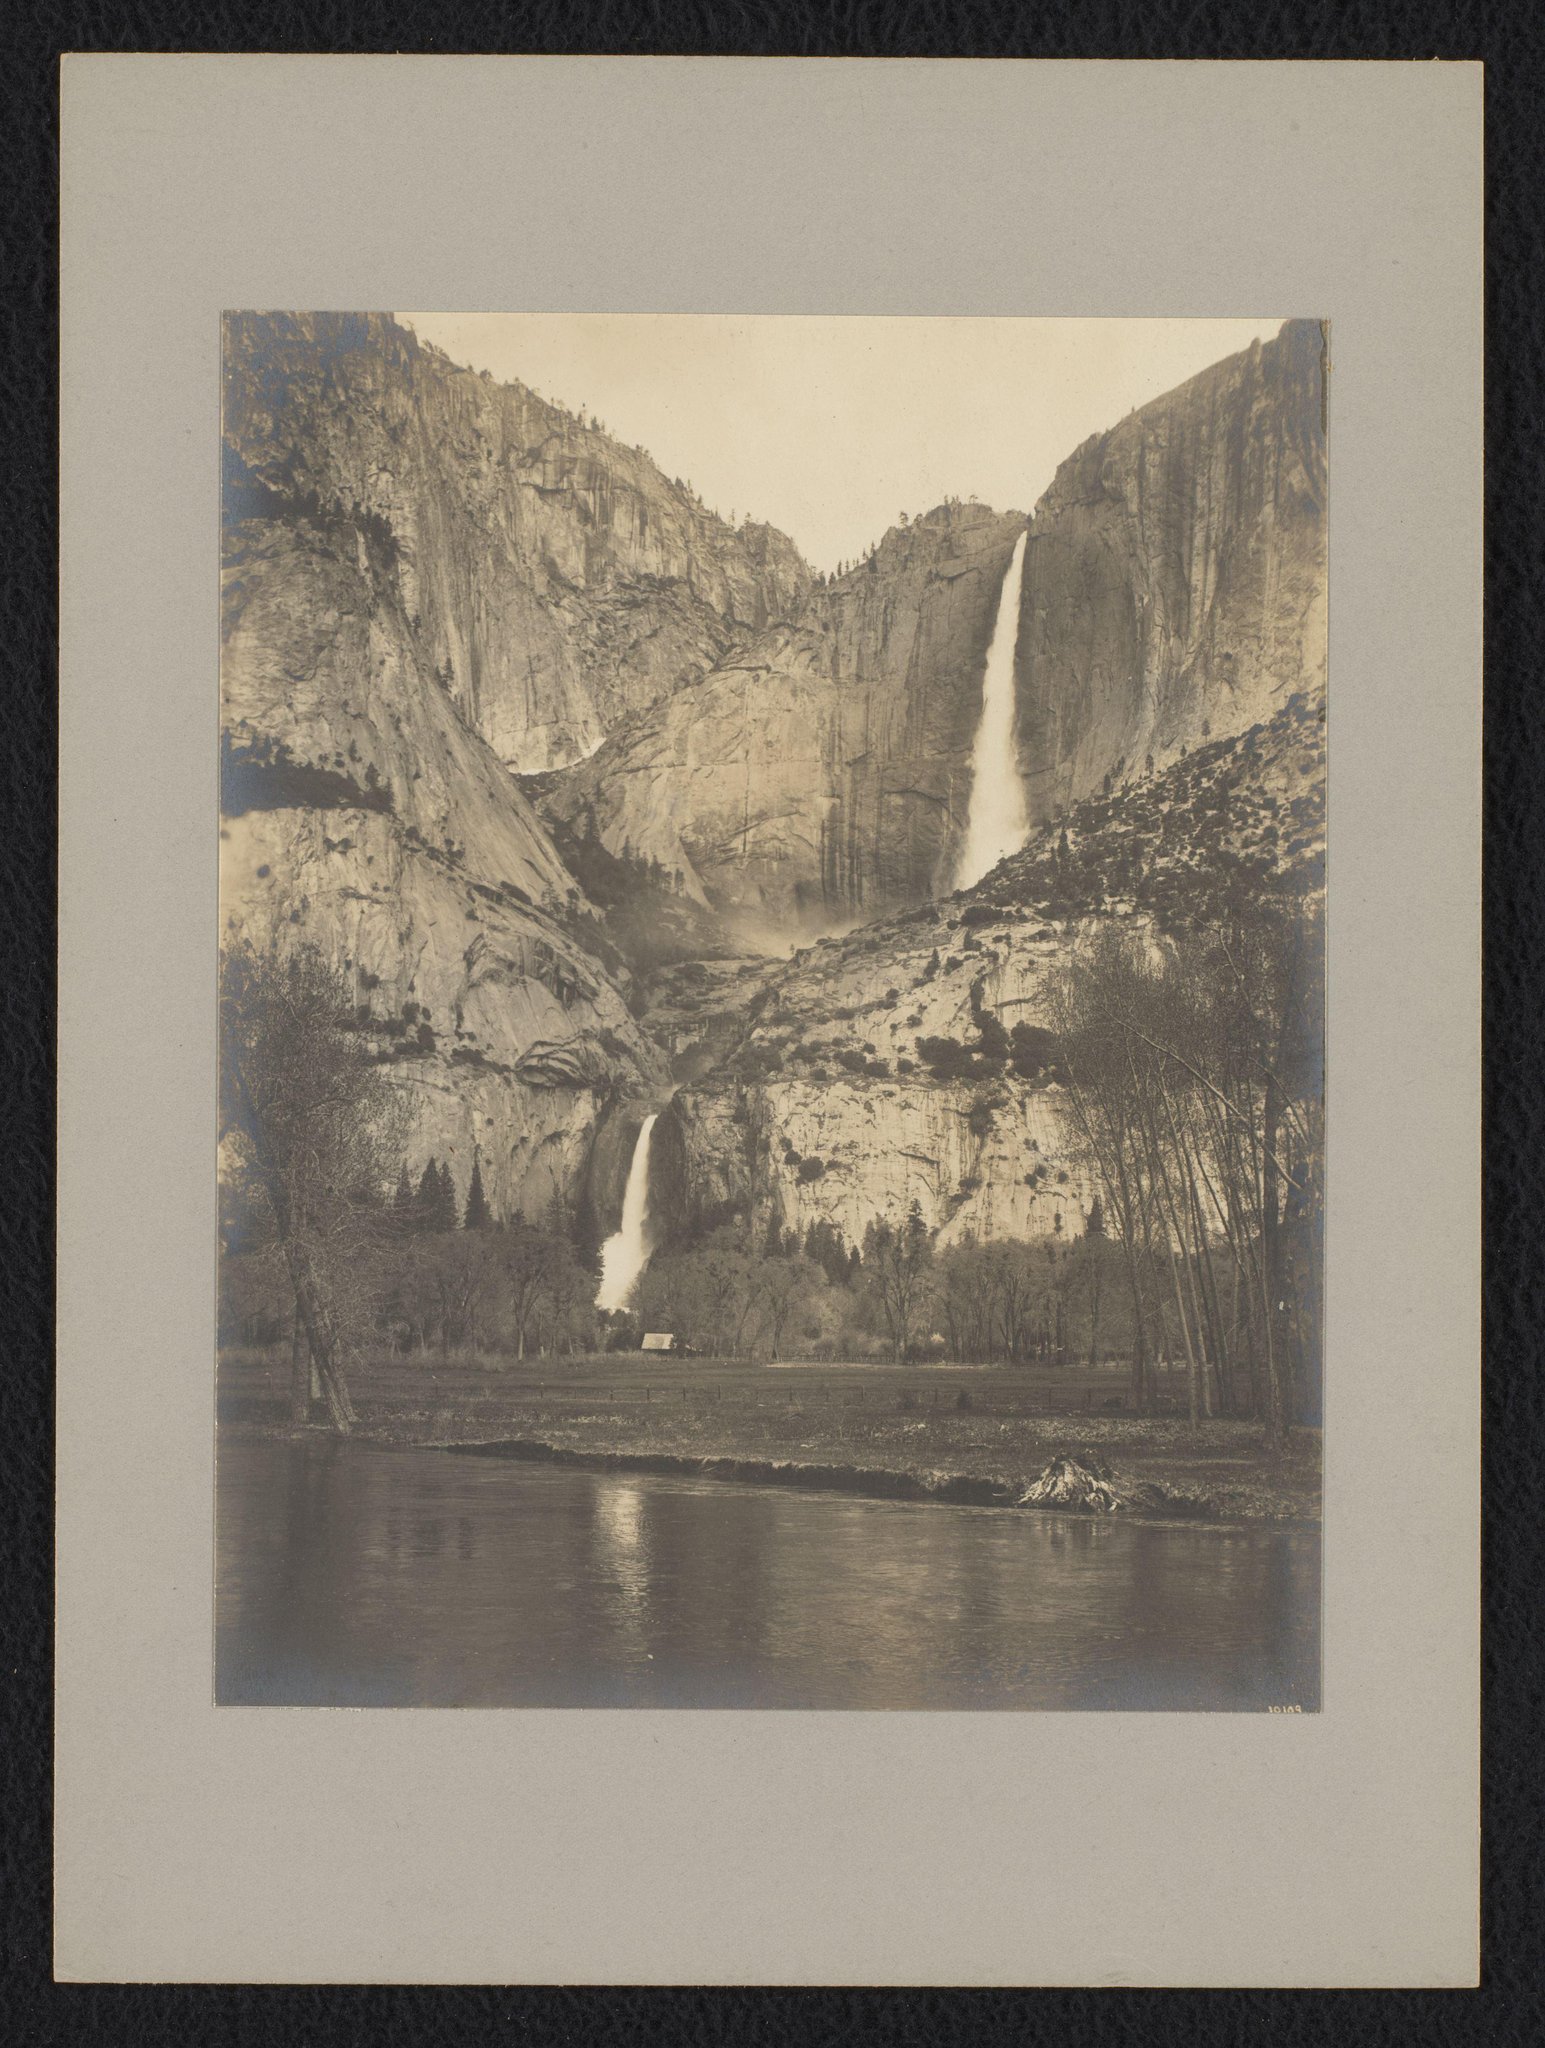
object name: photograph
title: Yosemite waterval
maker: Anonymous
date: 1895-1915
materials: cardboard, photographic support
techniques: gelatin silver print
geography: california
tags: californië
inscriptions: annotation: ‘2. Yosemete-fall.’